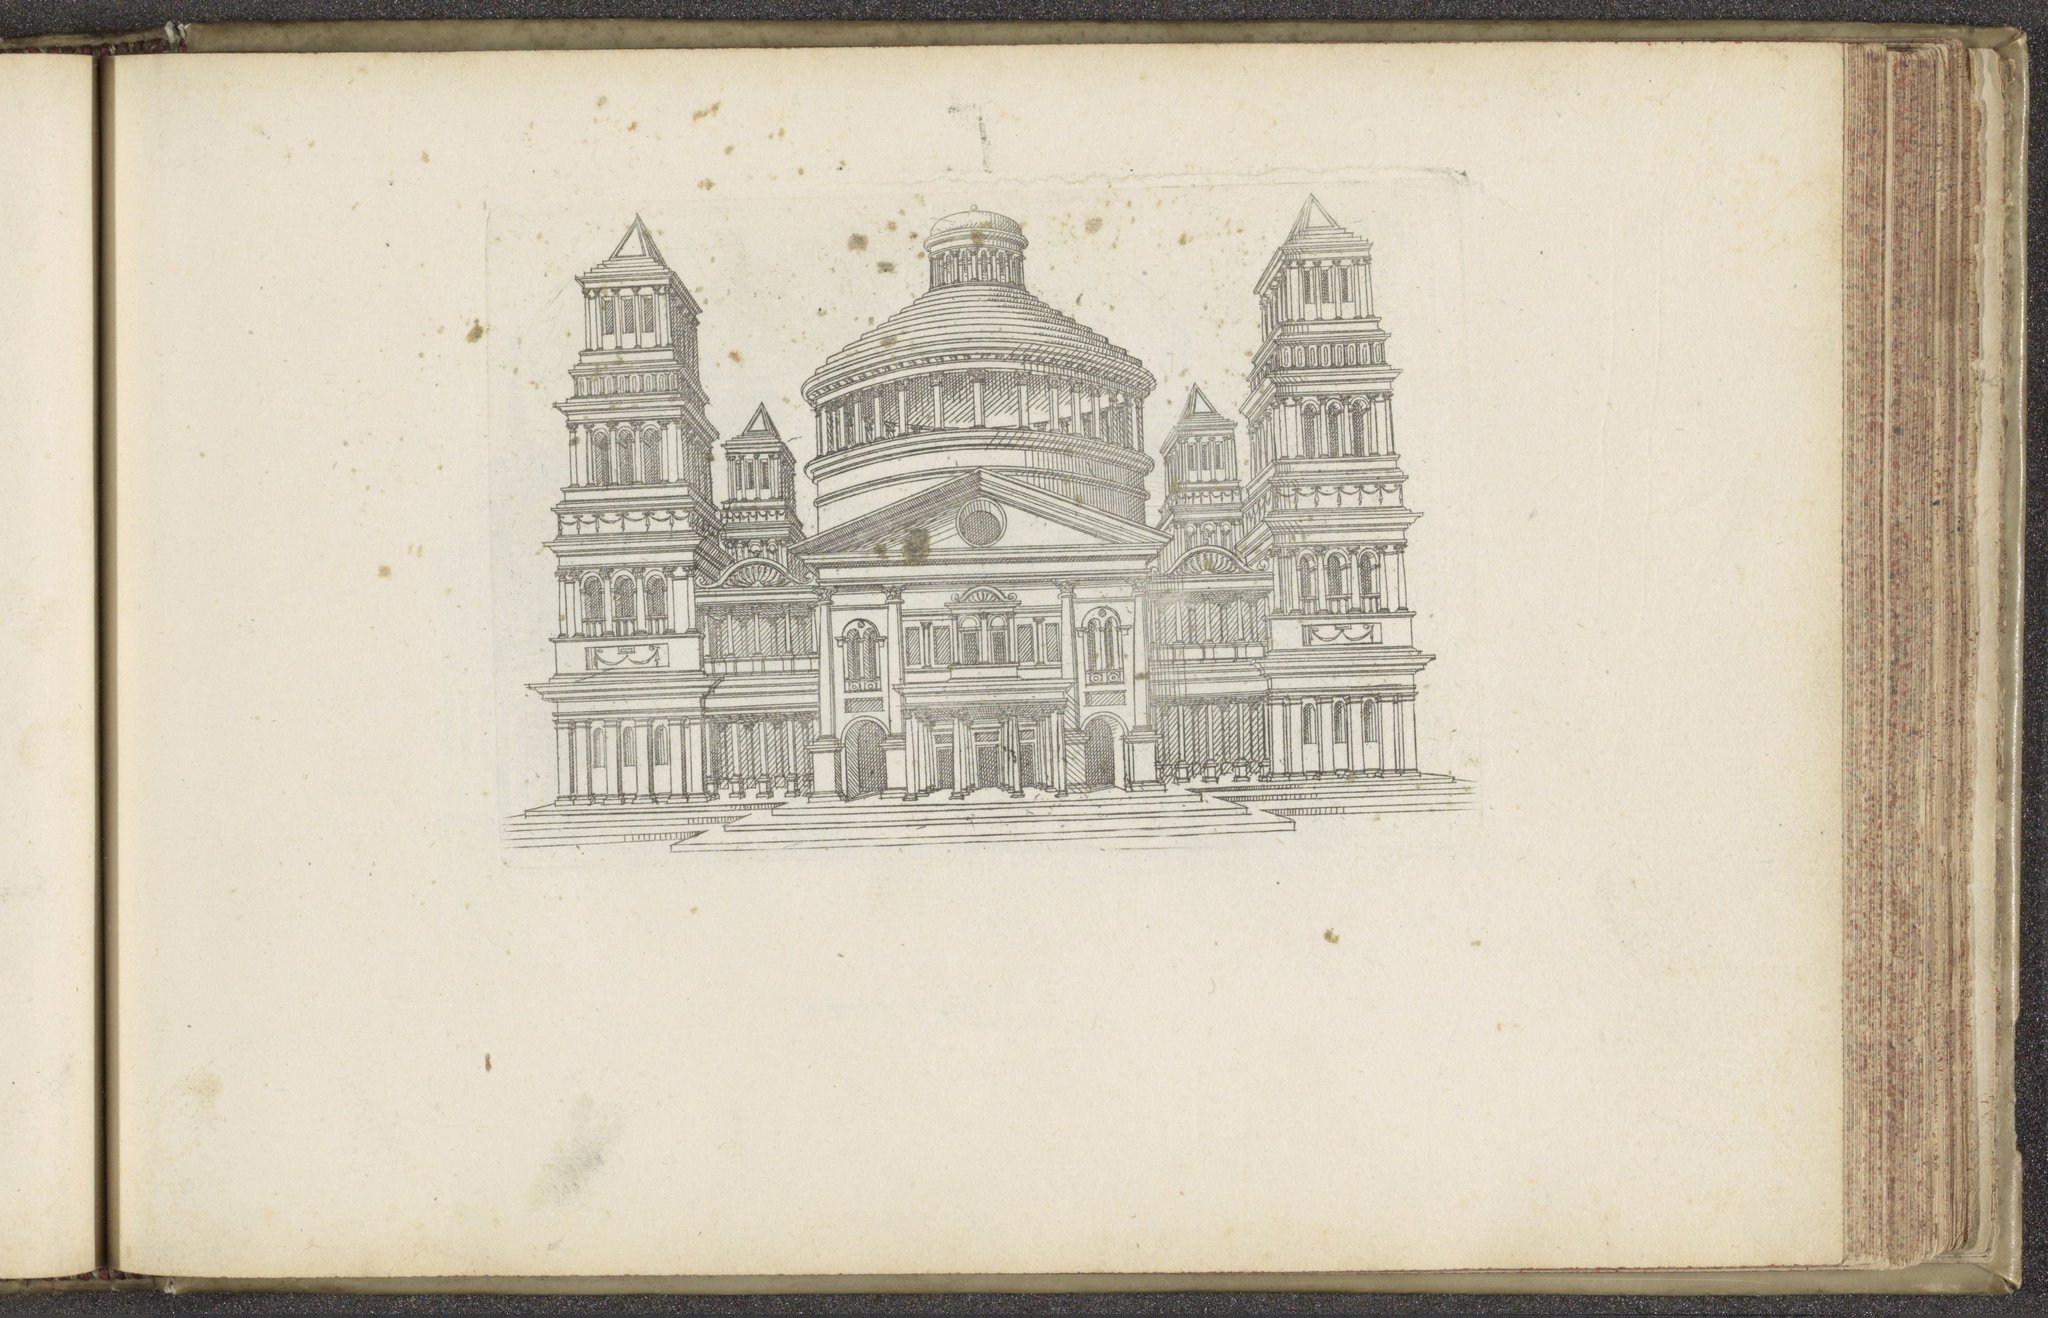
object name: album leaf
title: Heiligdom met centrale koepel en op de hoeken vier torens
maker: jacques androuet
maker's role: draughtsman, print maker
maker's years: 1515-1584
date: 1550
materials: paper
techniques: etching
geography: orléans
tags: exterior ~ representation of a building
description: Heiligdom met centrale koepel en op de hoeken vier torens. Deze prent maakt deel uit van een album.